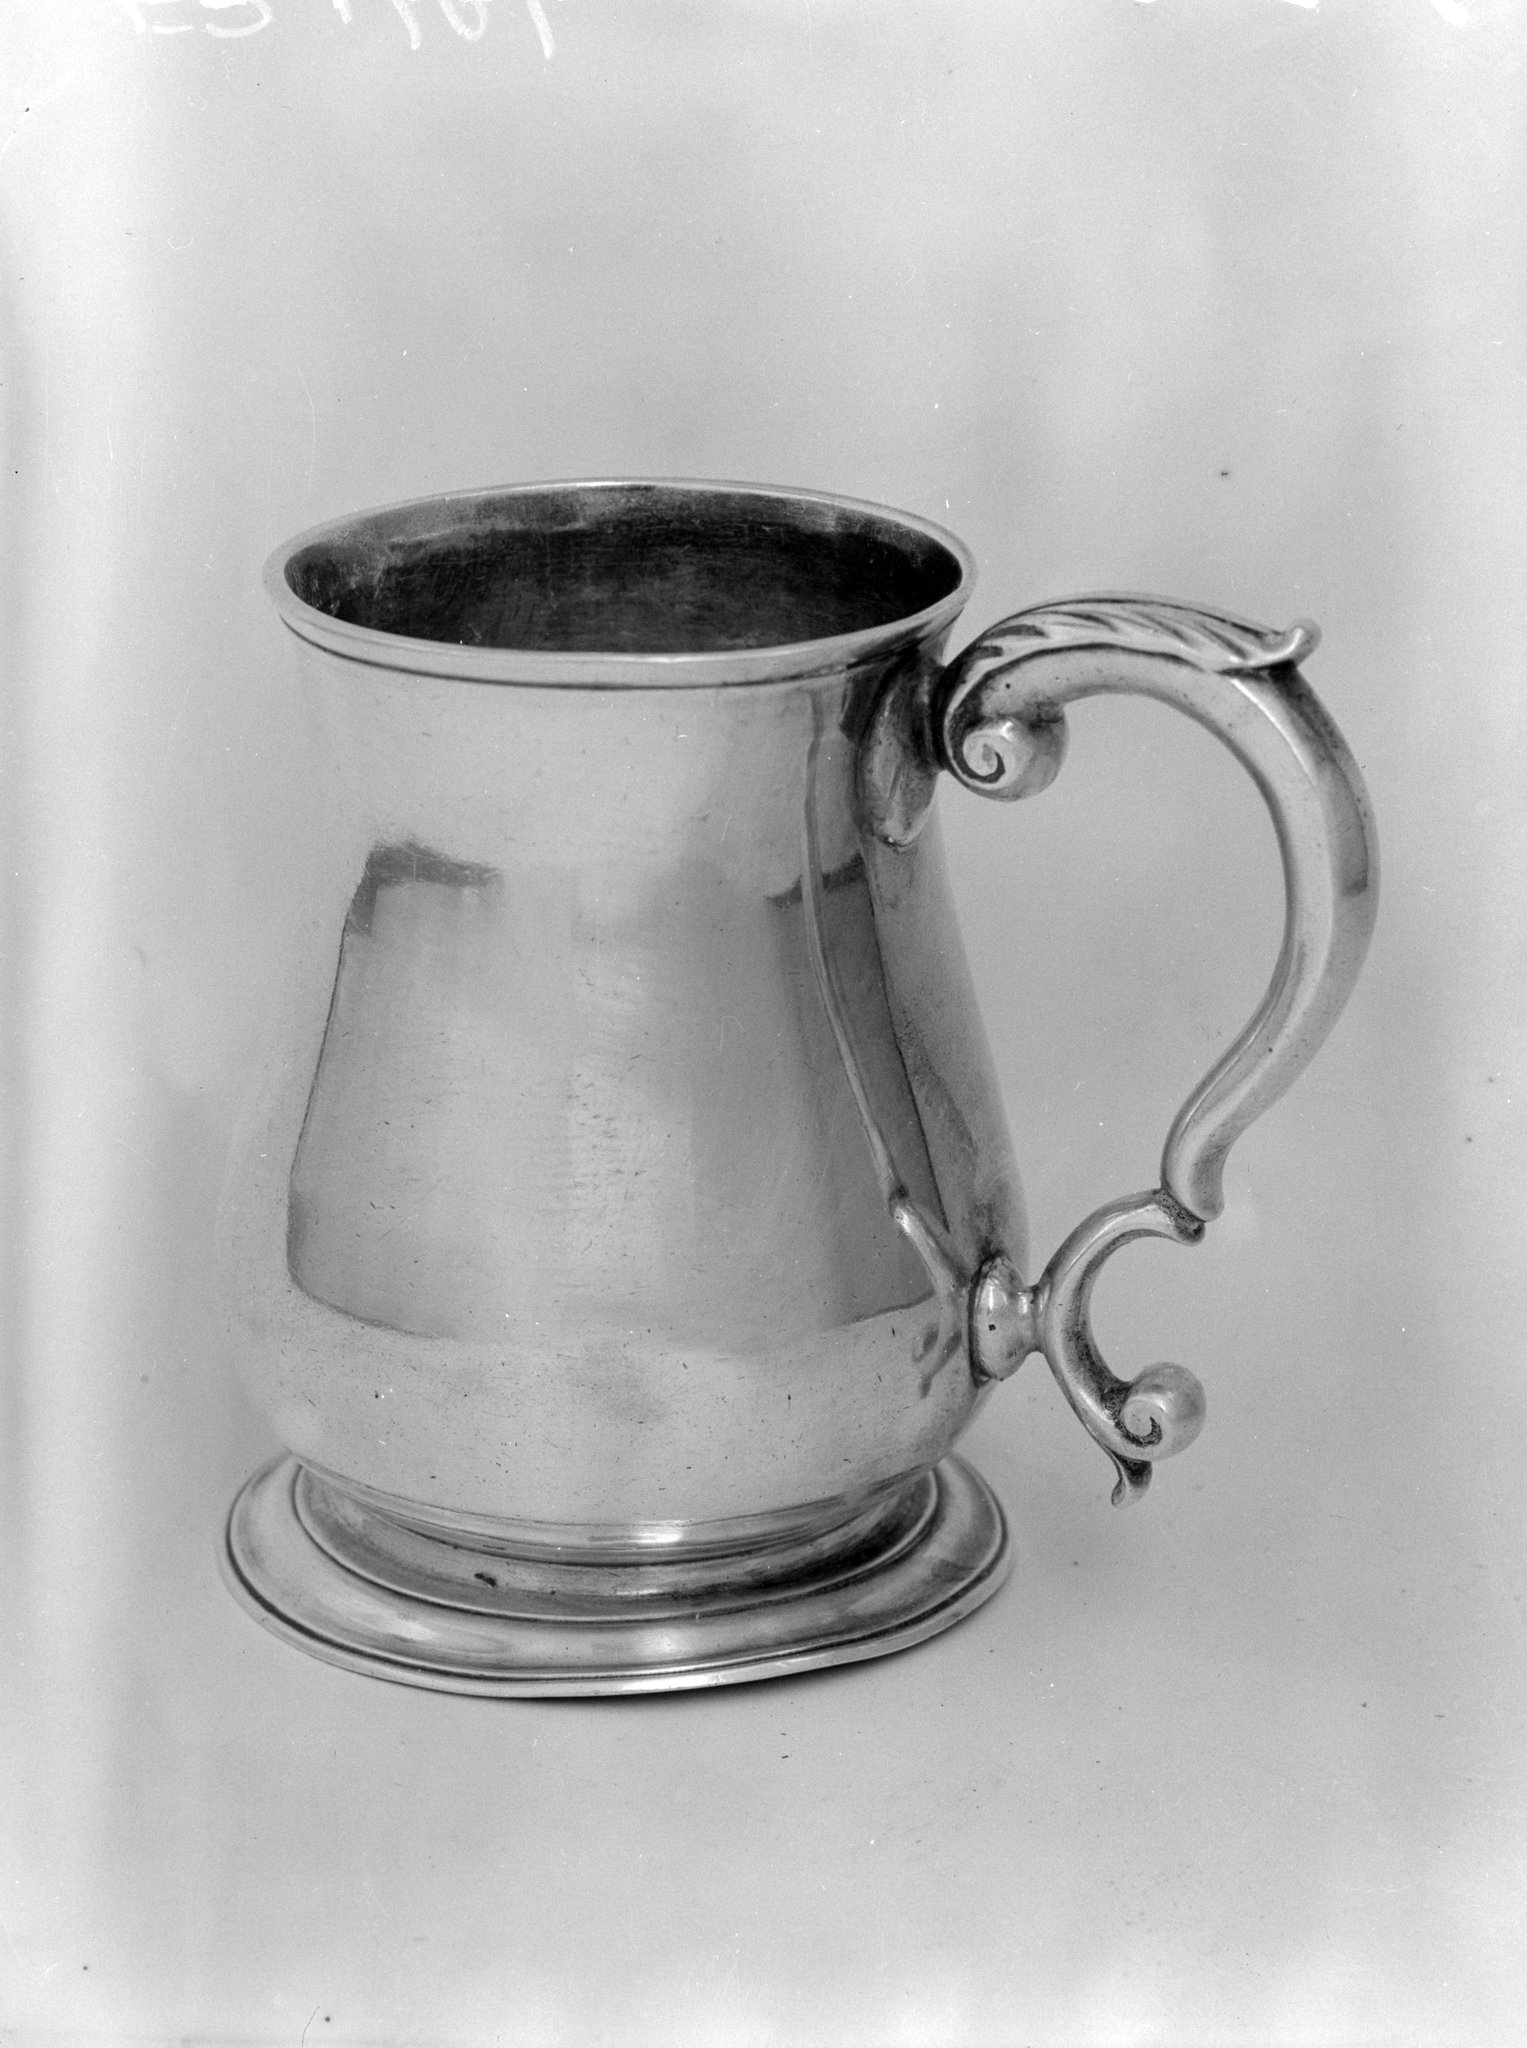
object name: mug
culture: british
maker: thomas gilpin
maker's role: maker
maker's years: 1730-1773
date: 1700-1800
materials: silver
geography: england